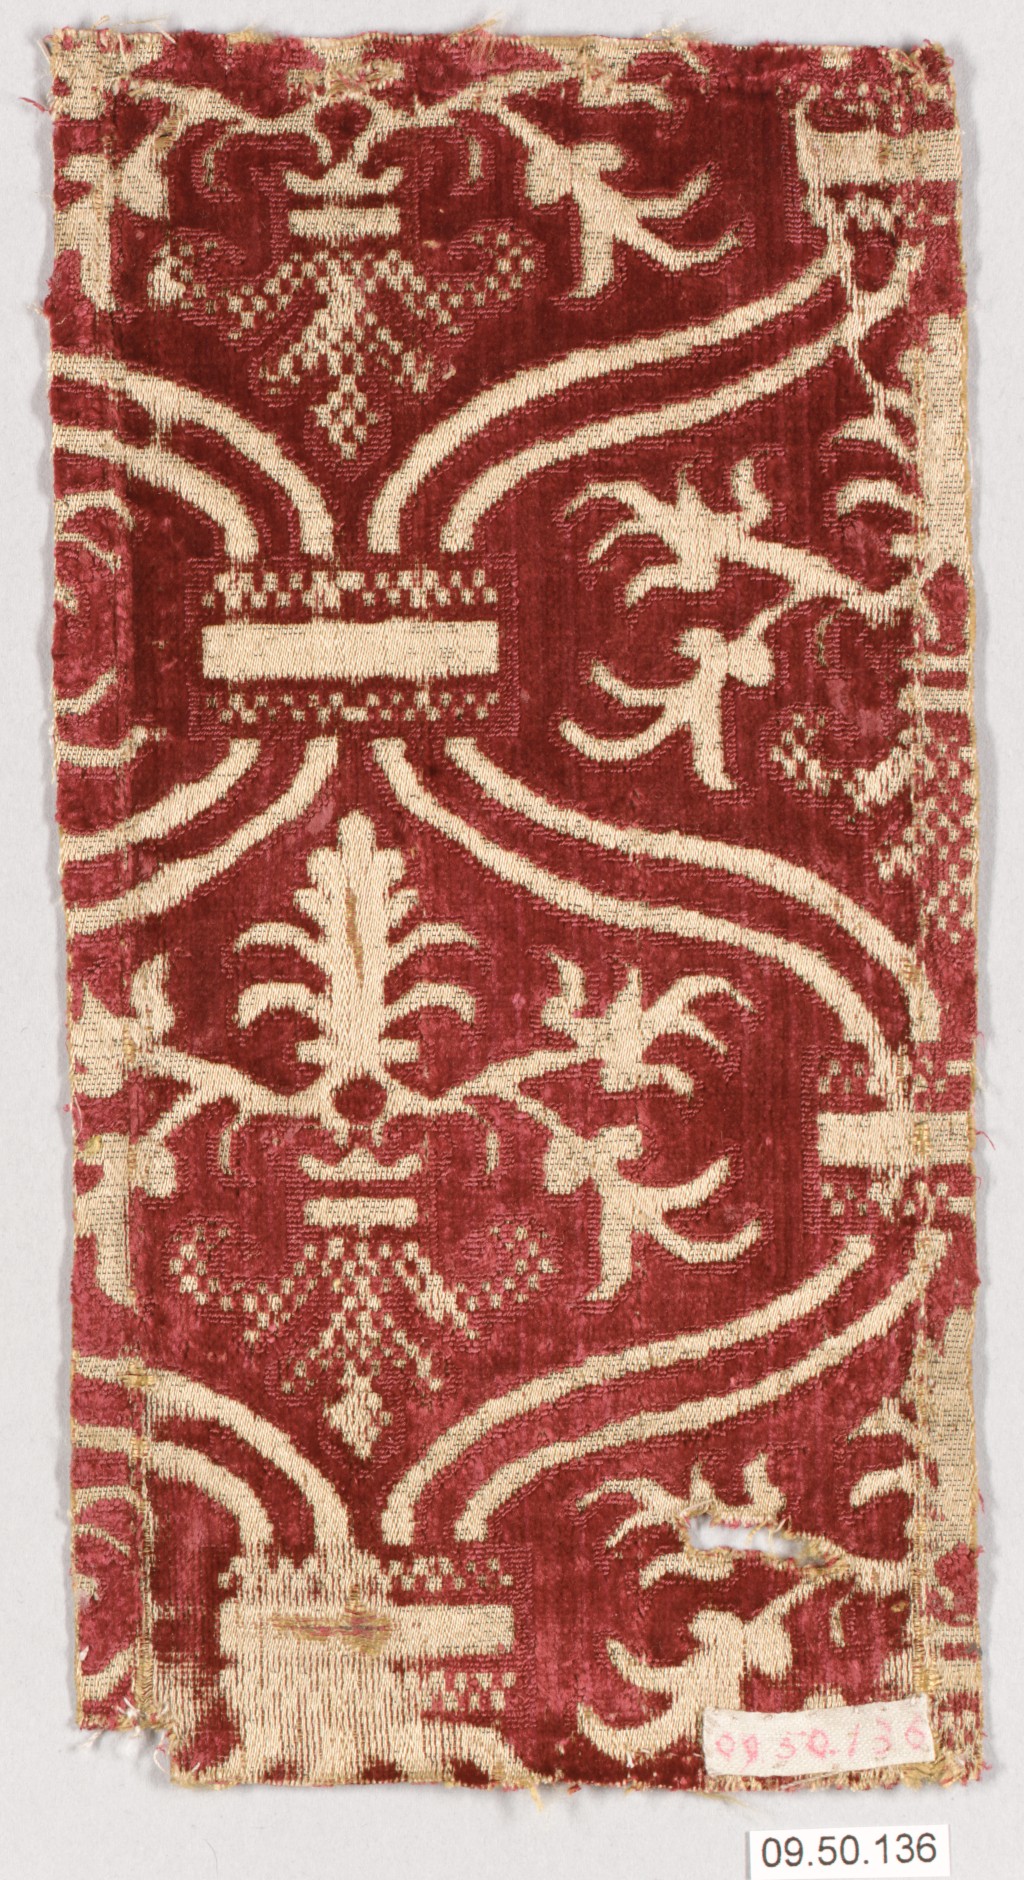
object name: piece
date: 1501-1700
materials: metal thread, silk